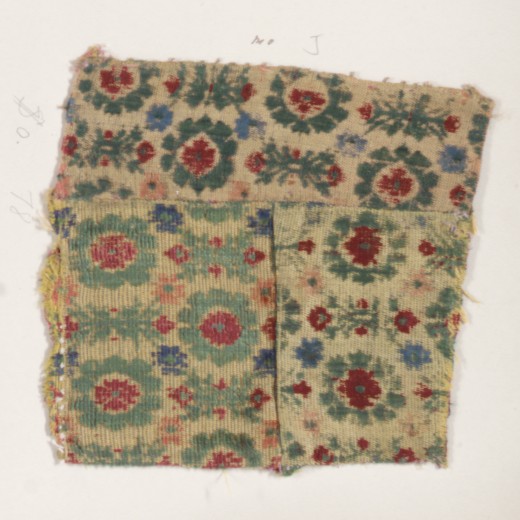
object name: fragment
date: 1701-1800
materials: metal thread, silk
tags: flowers